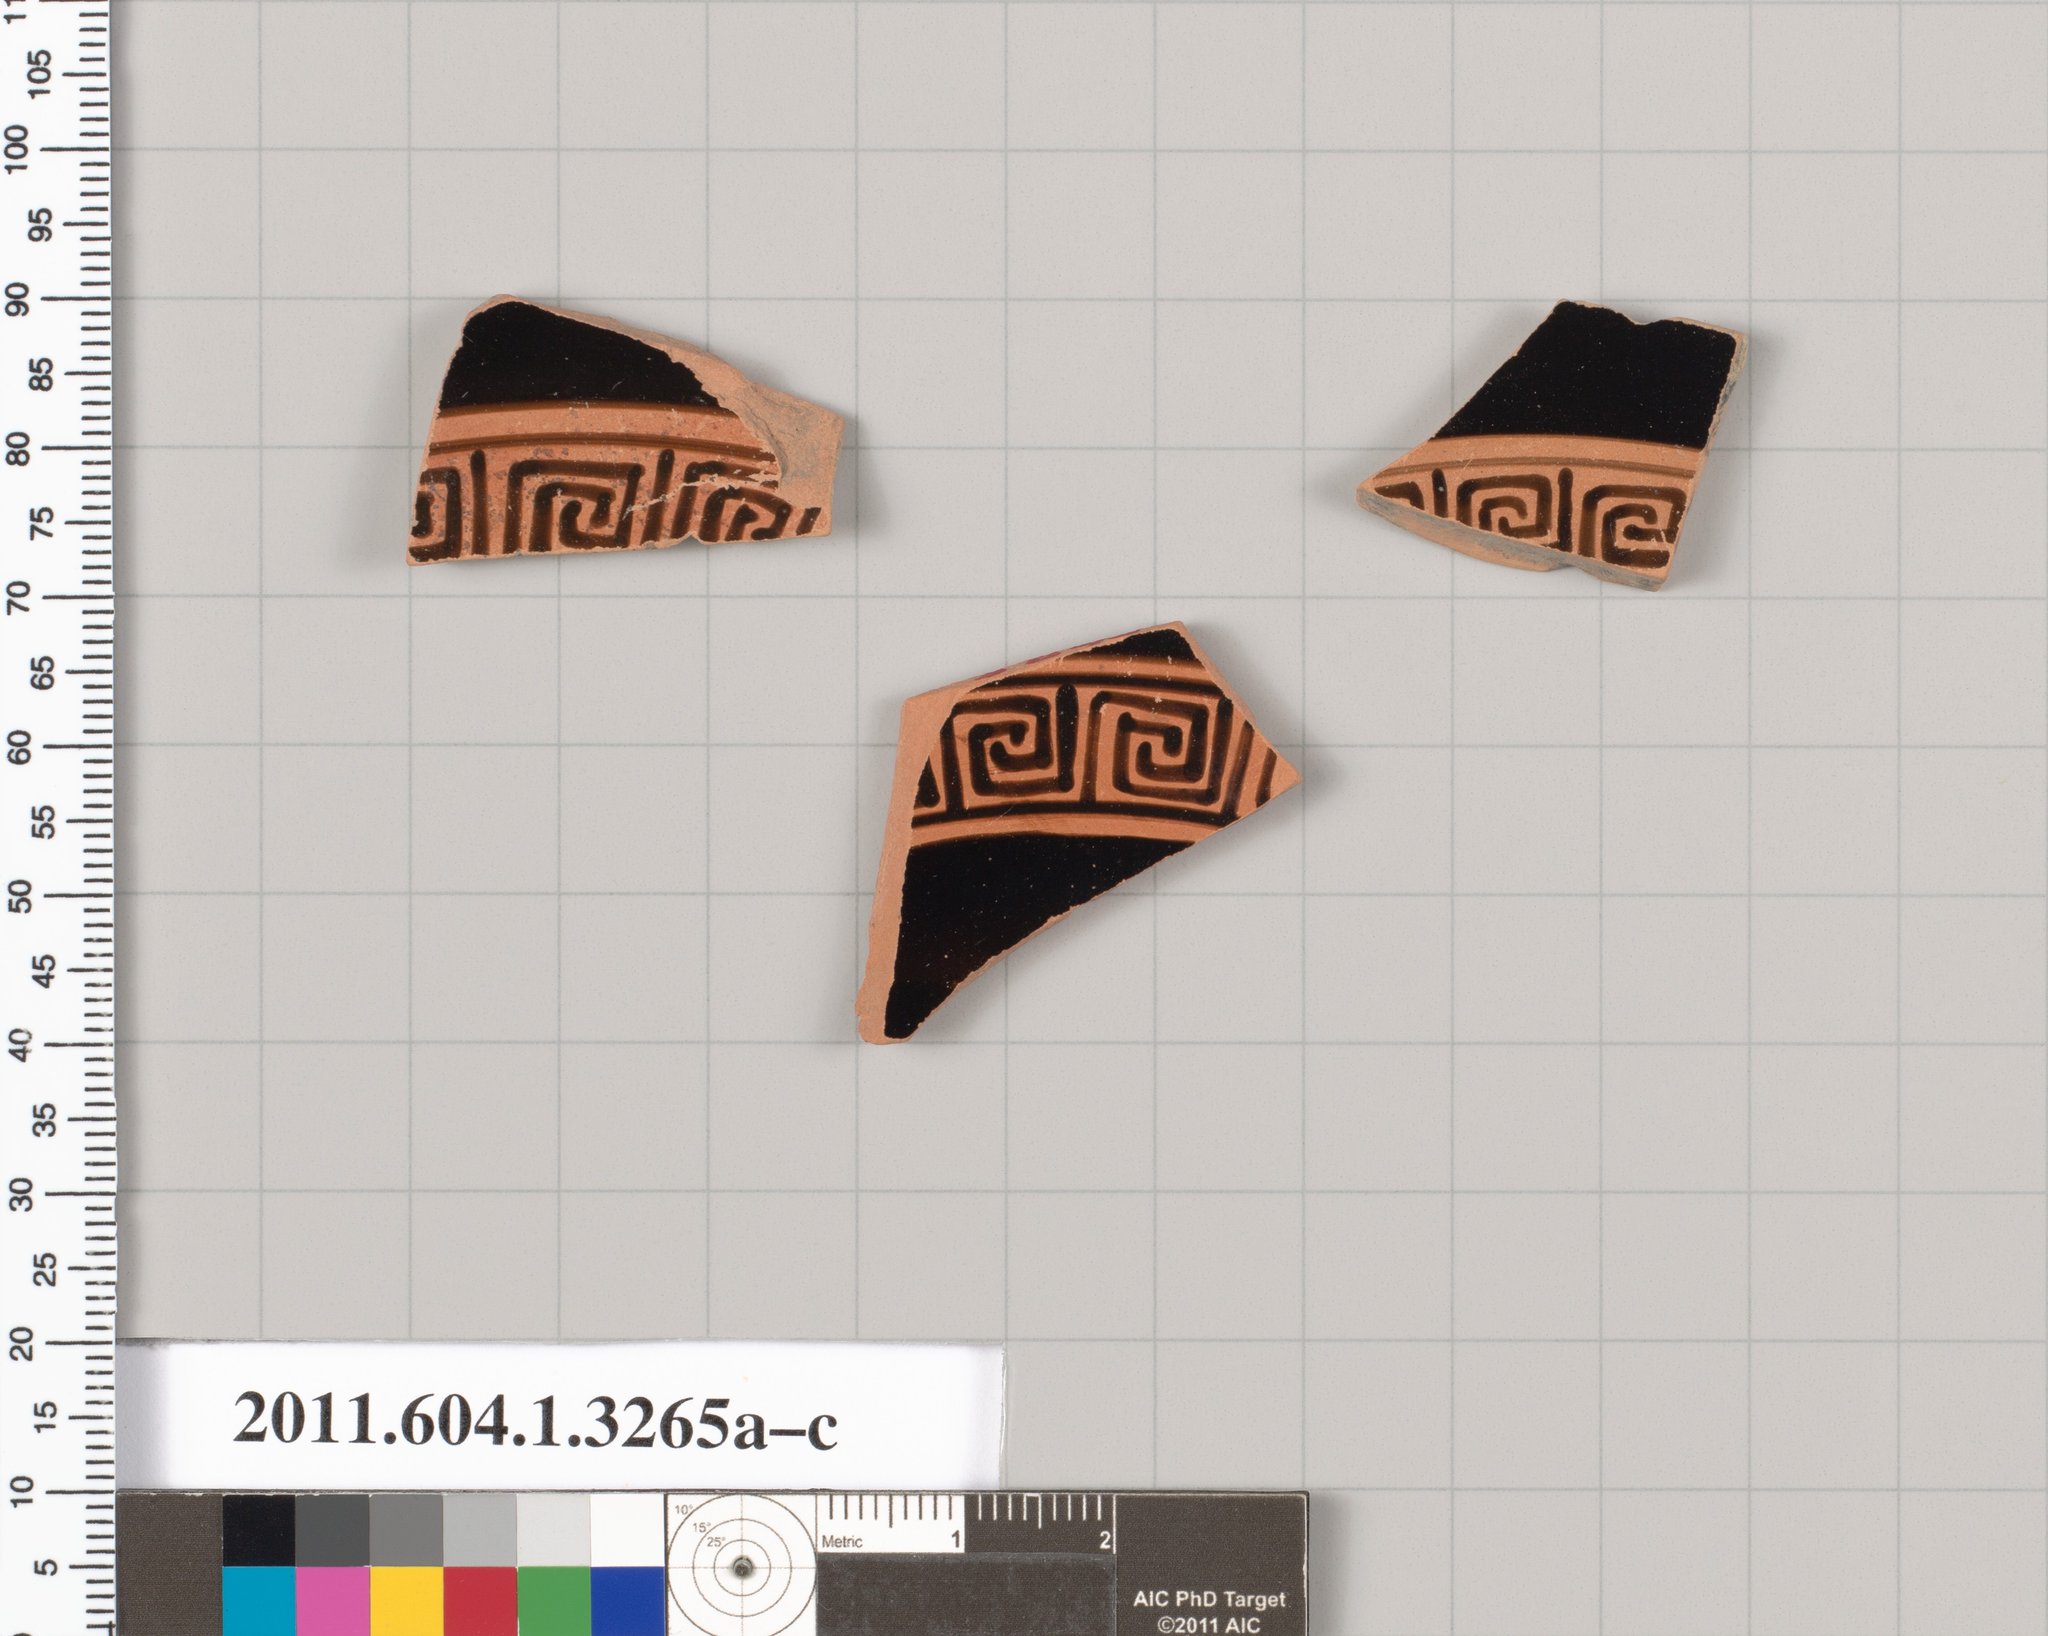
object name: kylix fragment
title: Terracotta fragments of kylikes (drinking cups)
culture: greek, attic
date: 500-490 BCE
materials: terracotta